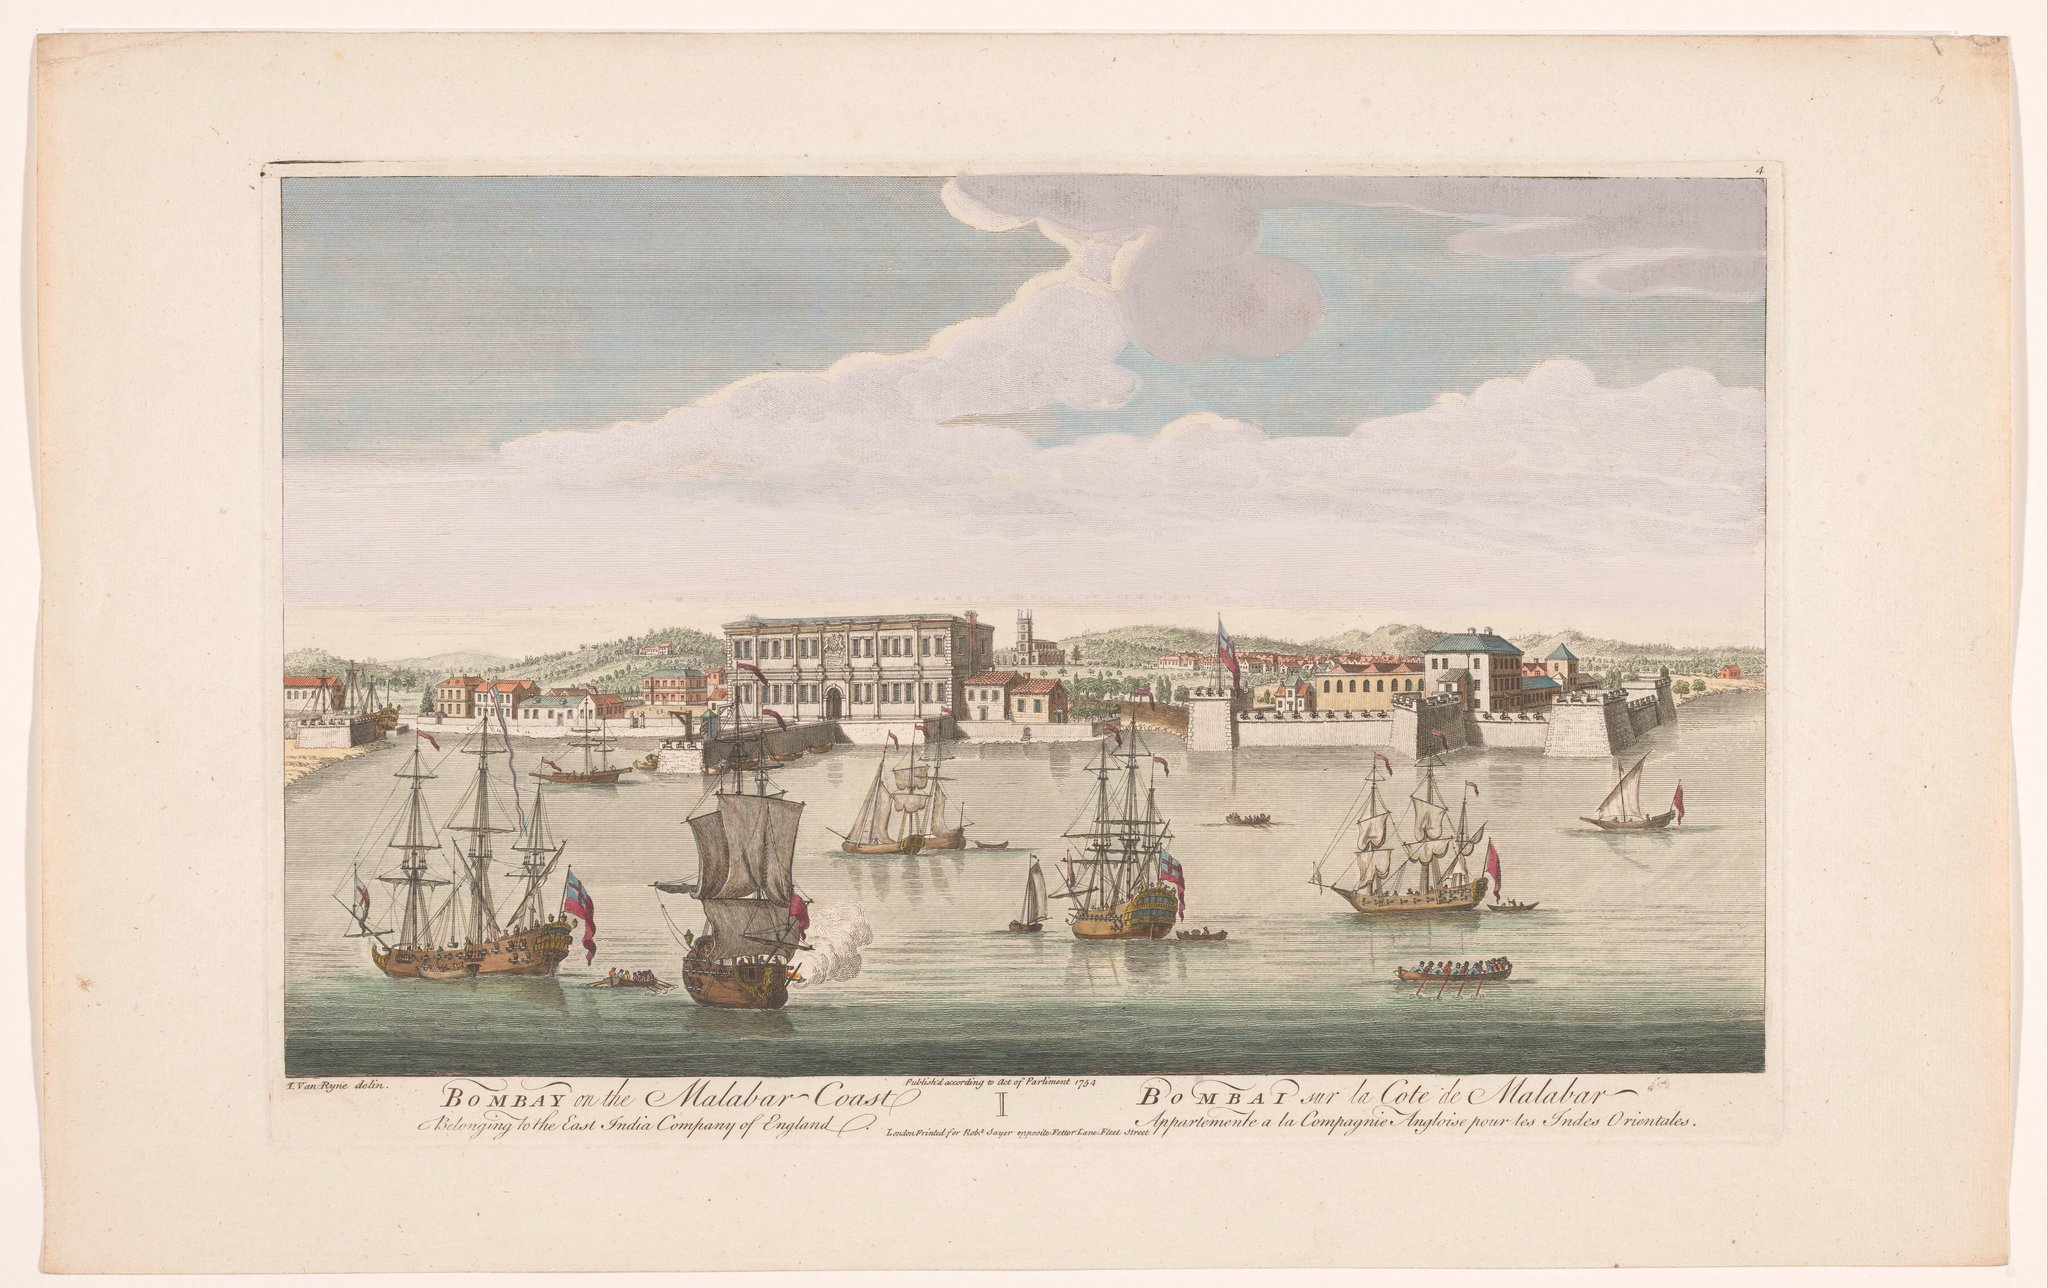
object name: print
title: Nederzettingen van de VOC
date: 1754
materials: paper, watercolor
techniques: brush, etching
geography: london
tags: sailing-ship, sailing-boat, rowing-boat, canoe, etc., sea (seascape) (+ landscape with figures, staffage), city-view in general; 'veduta' (+ city(-scape) with figures, staffage)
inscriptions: date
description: De serie “Nederzettingen van de VOC” bevat zes prenten met de nummers 1-6, waarvan dit nummer 2 is.